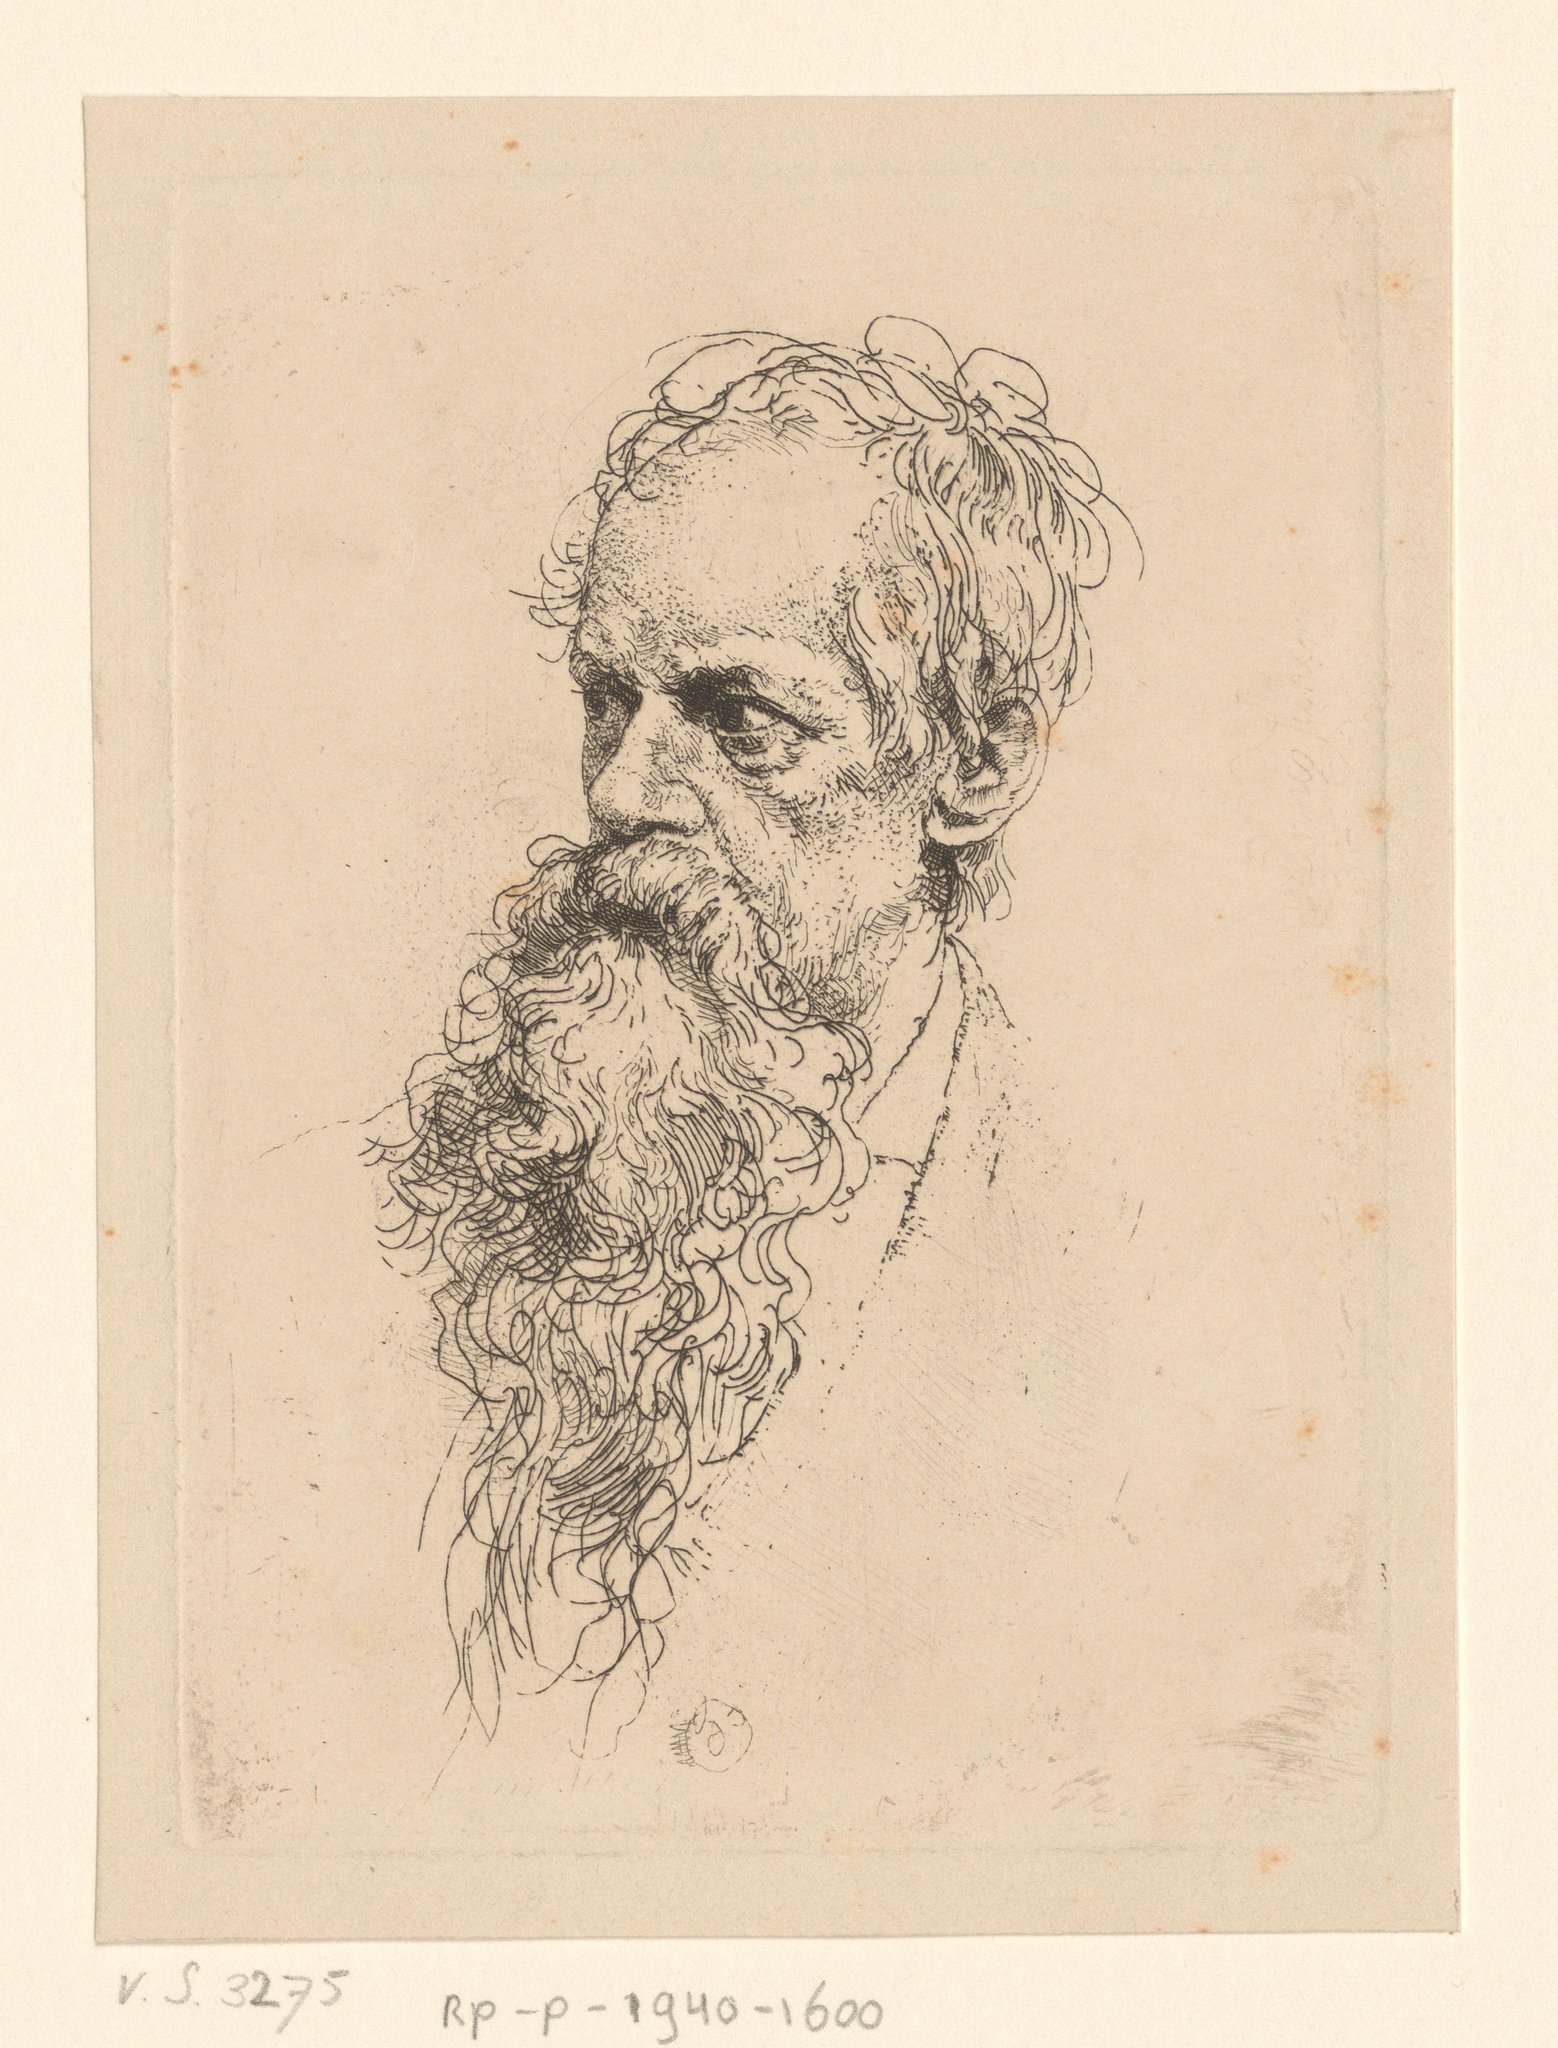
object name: print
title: Portret van Willem Linnig (I)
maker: willem linnig (ii)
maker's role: print maker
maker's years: 1842-1890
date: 1870-1886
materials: paper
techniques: etching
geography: antwerp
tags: willem linnig (i), historical persons, portrait, self-portrait of artist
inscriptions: collector's mark: Lugt 2760, collector's mark: Lugt 2228, collector's mark: Lugt 2166